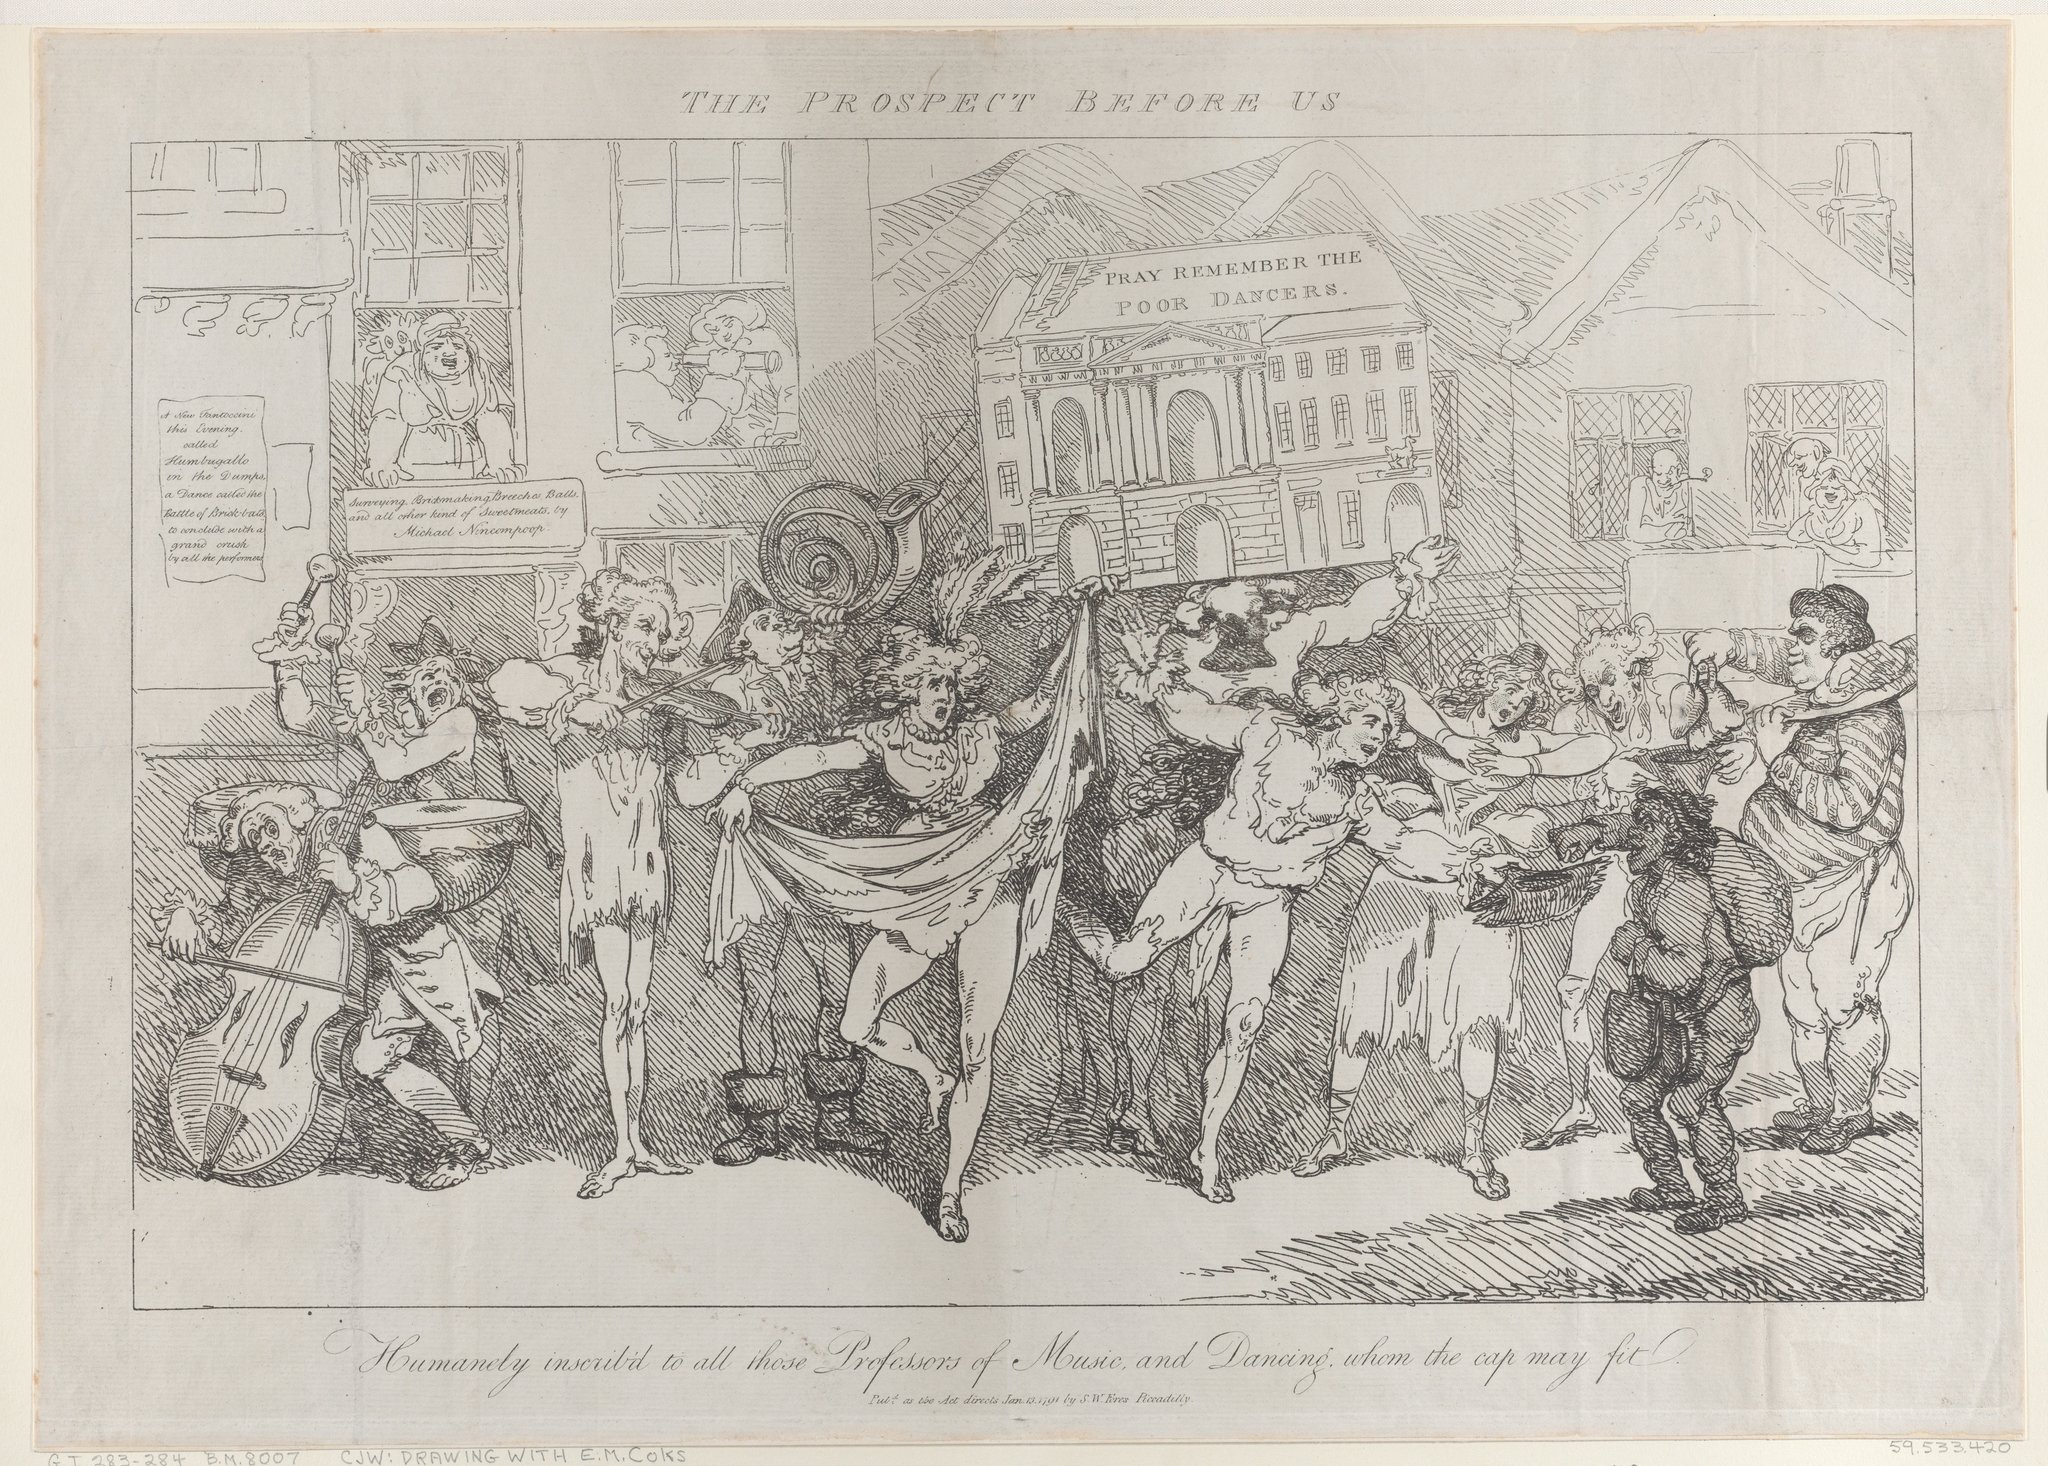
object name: print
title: The Prospect Before Us, Humanely Inscrib'd to all those Professors of Music and Dancing Whom the Cap May Fit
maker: thomas rowlandson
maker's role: artist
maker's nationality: british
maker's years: 1757-1827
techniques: etching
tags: satire,dancers,musicians